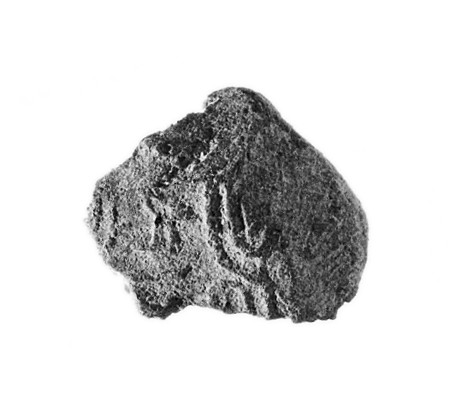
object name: sealing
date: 1981-1640 BCE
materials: mud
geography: egypt